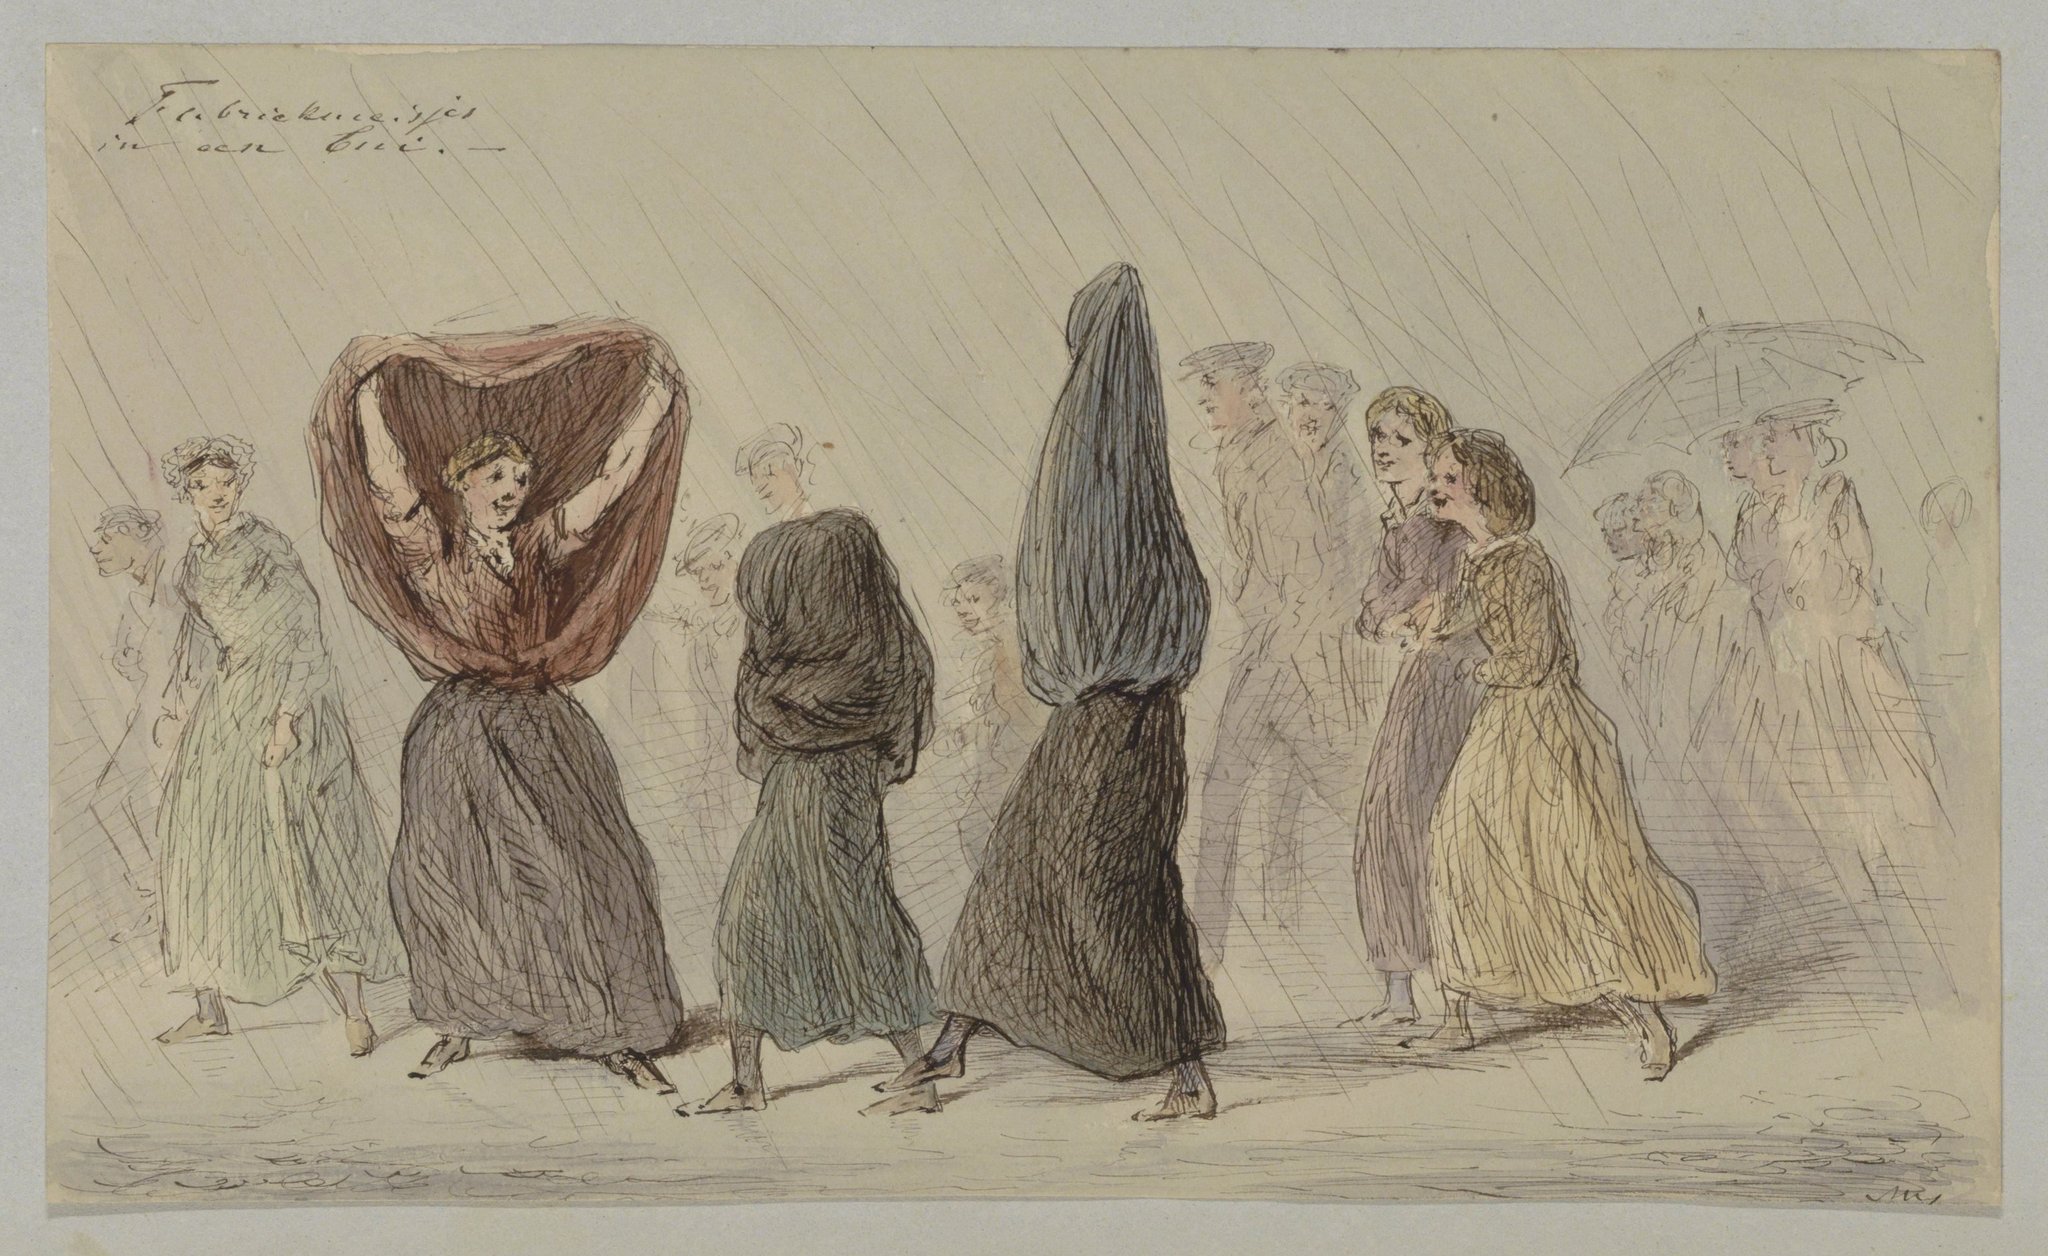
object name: album leaf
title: Fabrieksmeisjes in een regenbui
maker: alexander ver huell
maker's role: draughtsman, print maker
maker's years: 1822-1897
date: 1854-1887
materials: ink, paper, watercolor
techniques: brush, pen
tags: downpour, rain shower, working class, labourers - aa - women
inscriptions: annotation: ‘Fabrieksmeisjes/ in een bui.-’, signature: ‘Avh’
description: Drie van de meisjes tillen hun rok op en houden deze boven het hoofd om niet nat te worden. Tekening 2 op blad 3 van een album met 35 tekeningen.